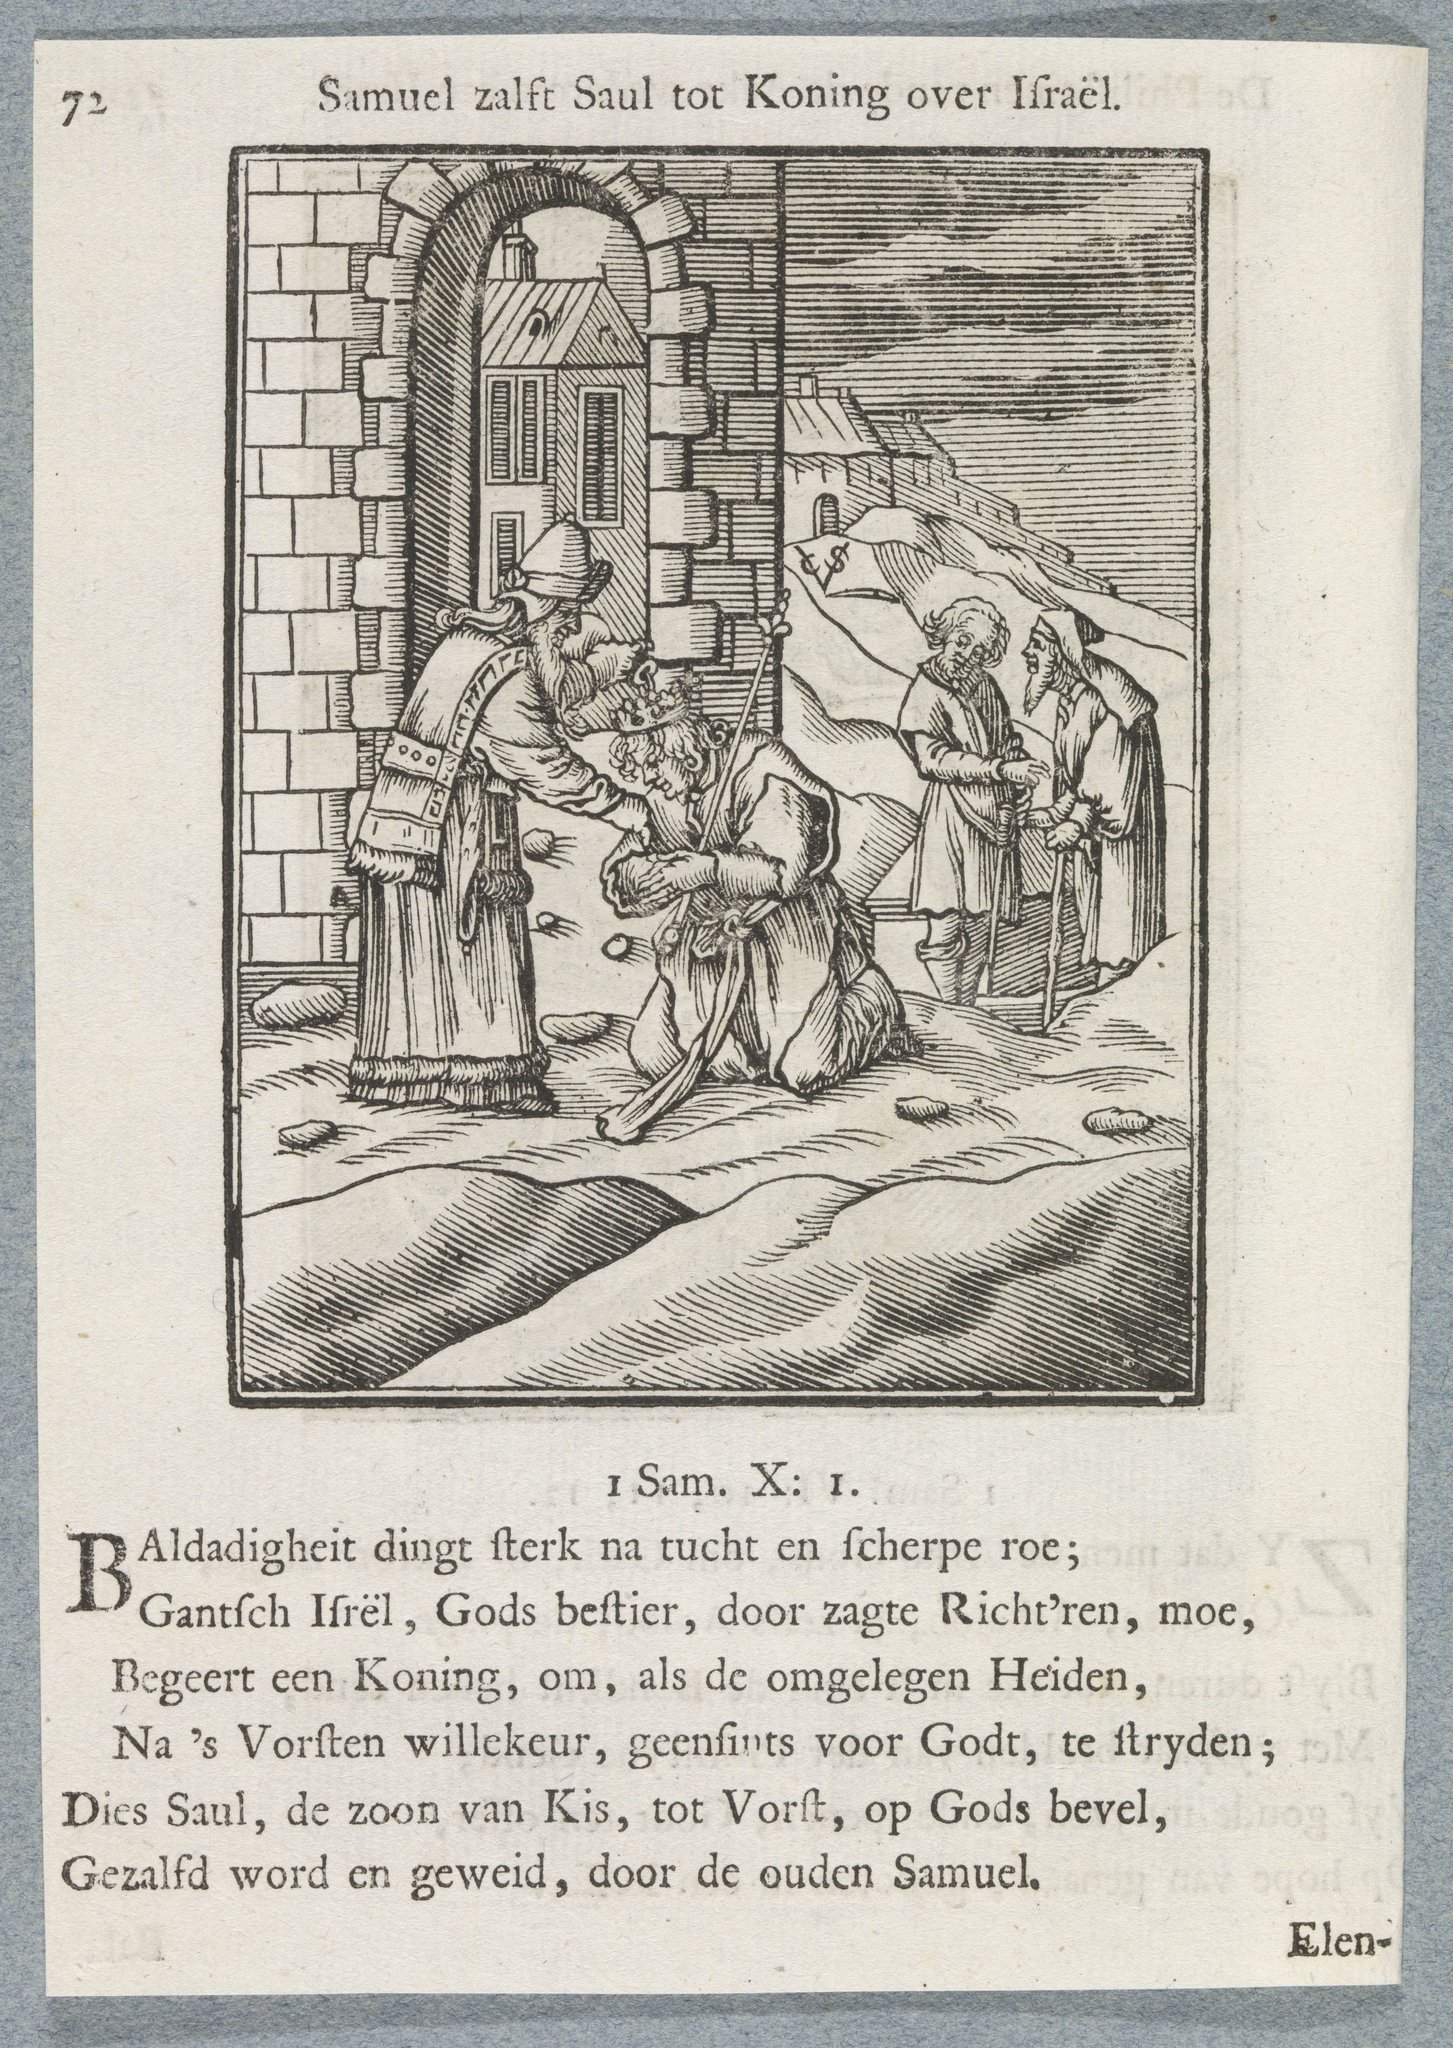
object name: album leaf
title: Samuel zalft Saul tot koning over Israël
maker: jan klooster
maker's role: bookseller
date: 1645-1646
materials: paper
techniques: letterpress printing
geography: amsterdam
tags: the anointment of saul by samuel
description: De prent is afkomstig uit: Bybels Lusthof. Amsterdam, J. Klooster, 1740. De prent werd gemaakt voor de uitgaven van P.J. Paets uit Amsterdam. Ze komt in ieder geval voor in: Bibels Tresoor ofte der zielen lusthof. Amsterdam, P.J. Paets, 1646. Mogelijk staat ze ook in: Historien ende Prophetien. [Amsterdam], P.J. Paets, 1645.